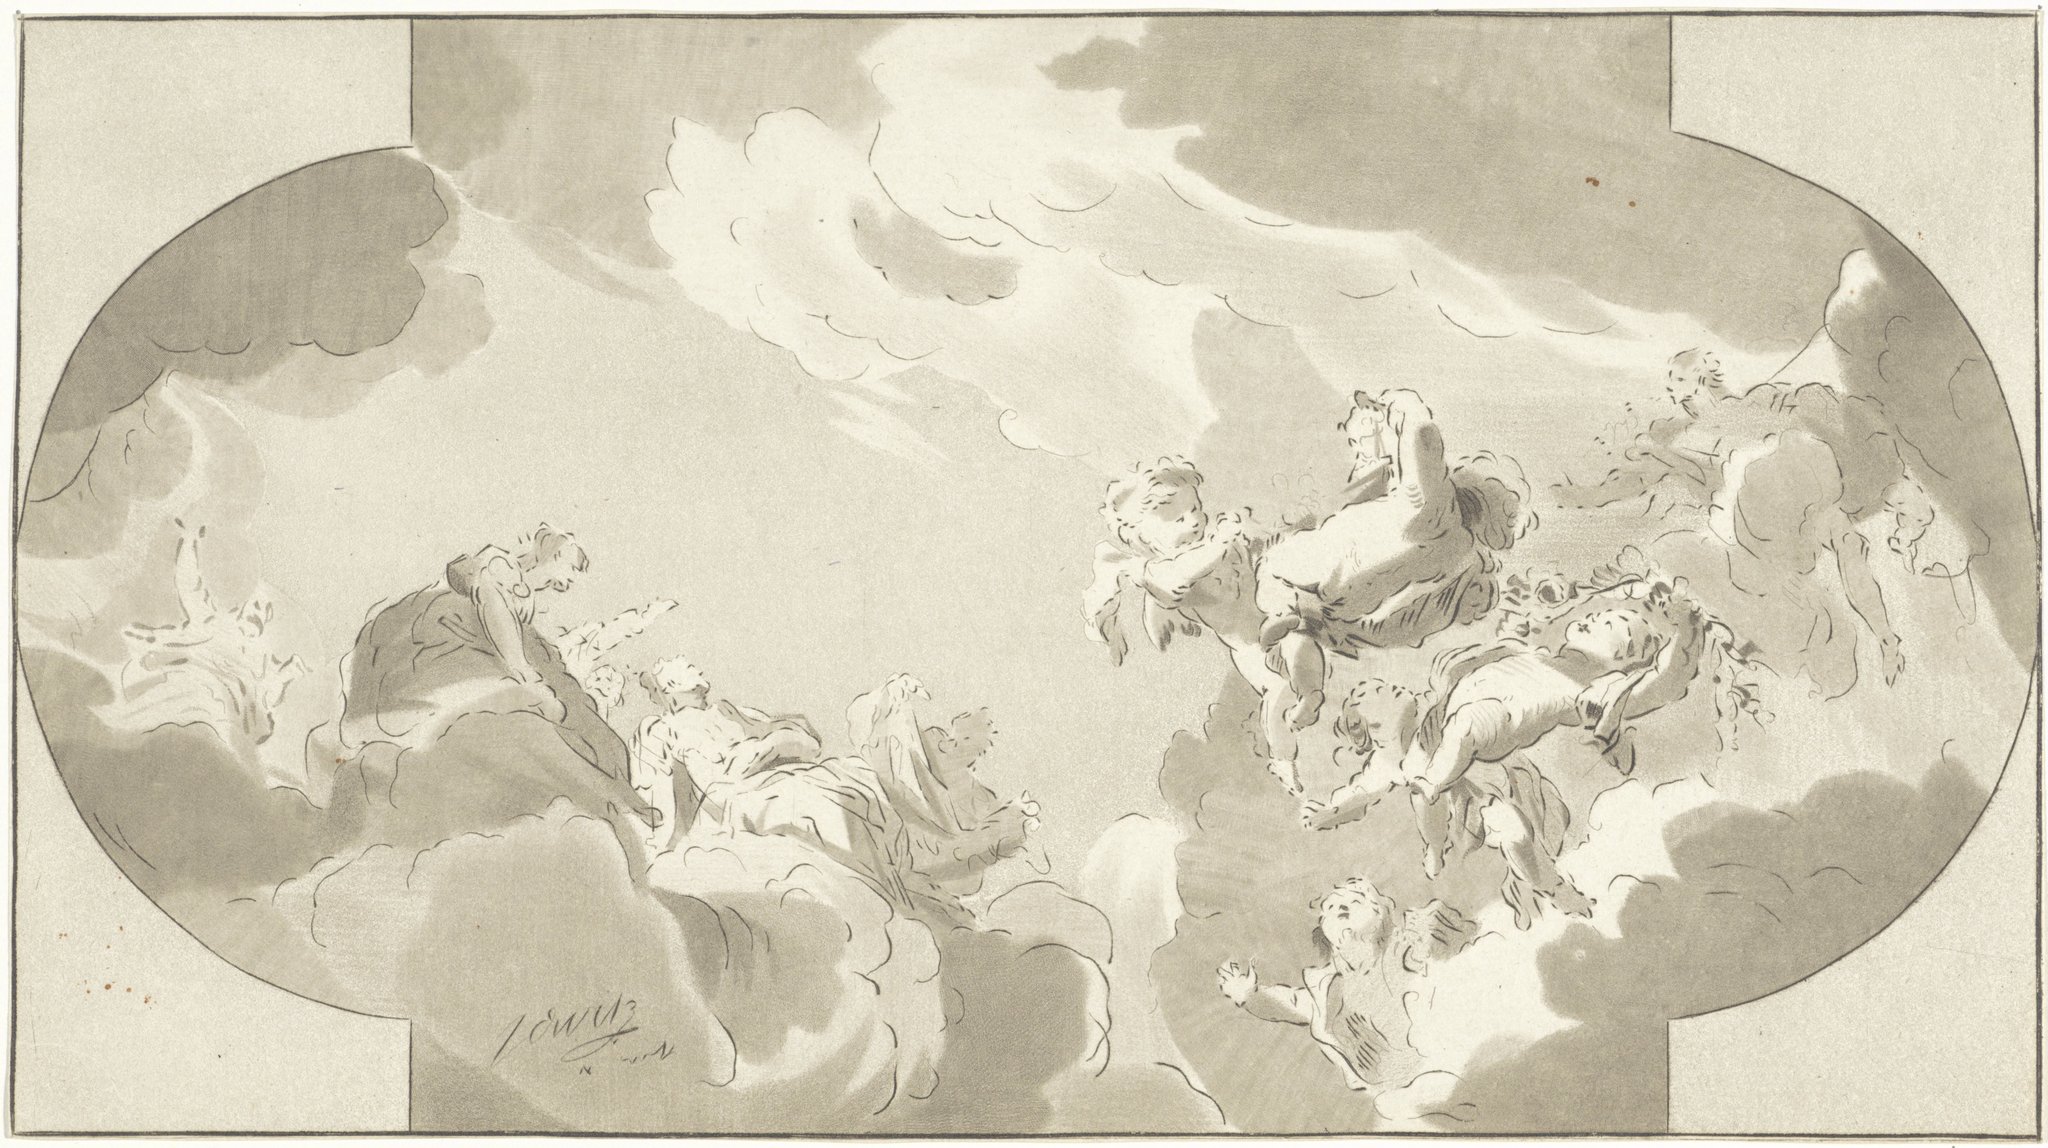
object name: print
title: Plafondontwerp met putti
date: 1767-1780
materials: paper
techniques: etching, rocker stamped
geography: netherlands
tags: cupids: 'amores', 'amoretti', 'putti'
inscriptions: collector's mark: Lugt 2228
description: Plafondontwerp met goden op de wolken en vliegende putti met bloemenkransen.